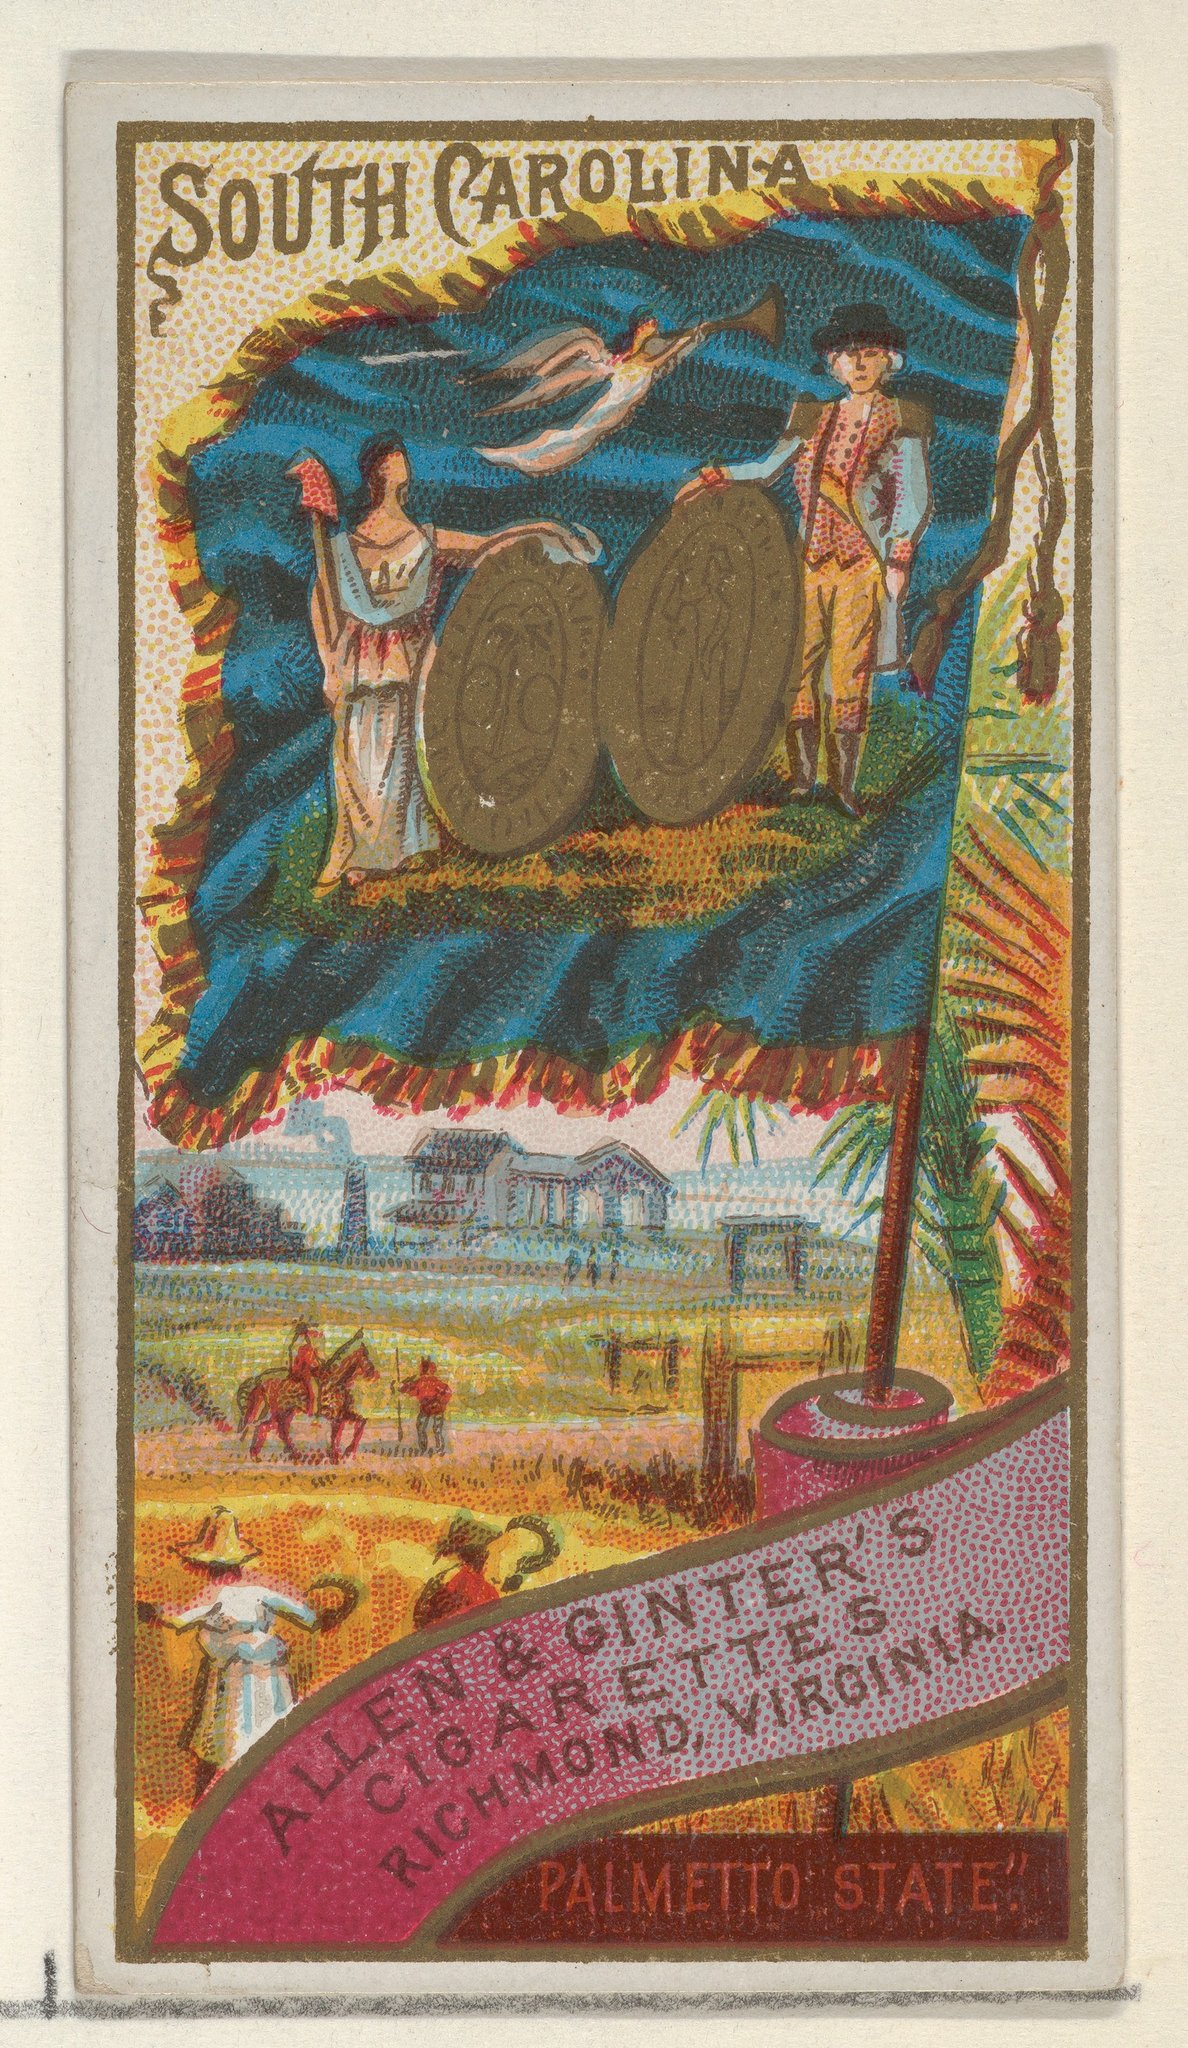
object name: print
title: South Carolina, from Flags of the States and Territories (N11) for Allen & Ginter Cigarettes Brands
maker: allen & ginter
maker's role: publisher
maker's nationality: american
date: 1888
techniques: color lithograph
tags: flags